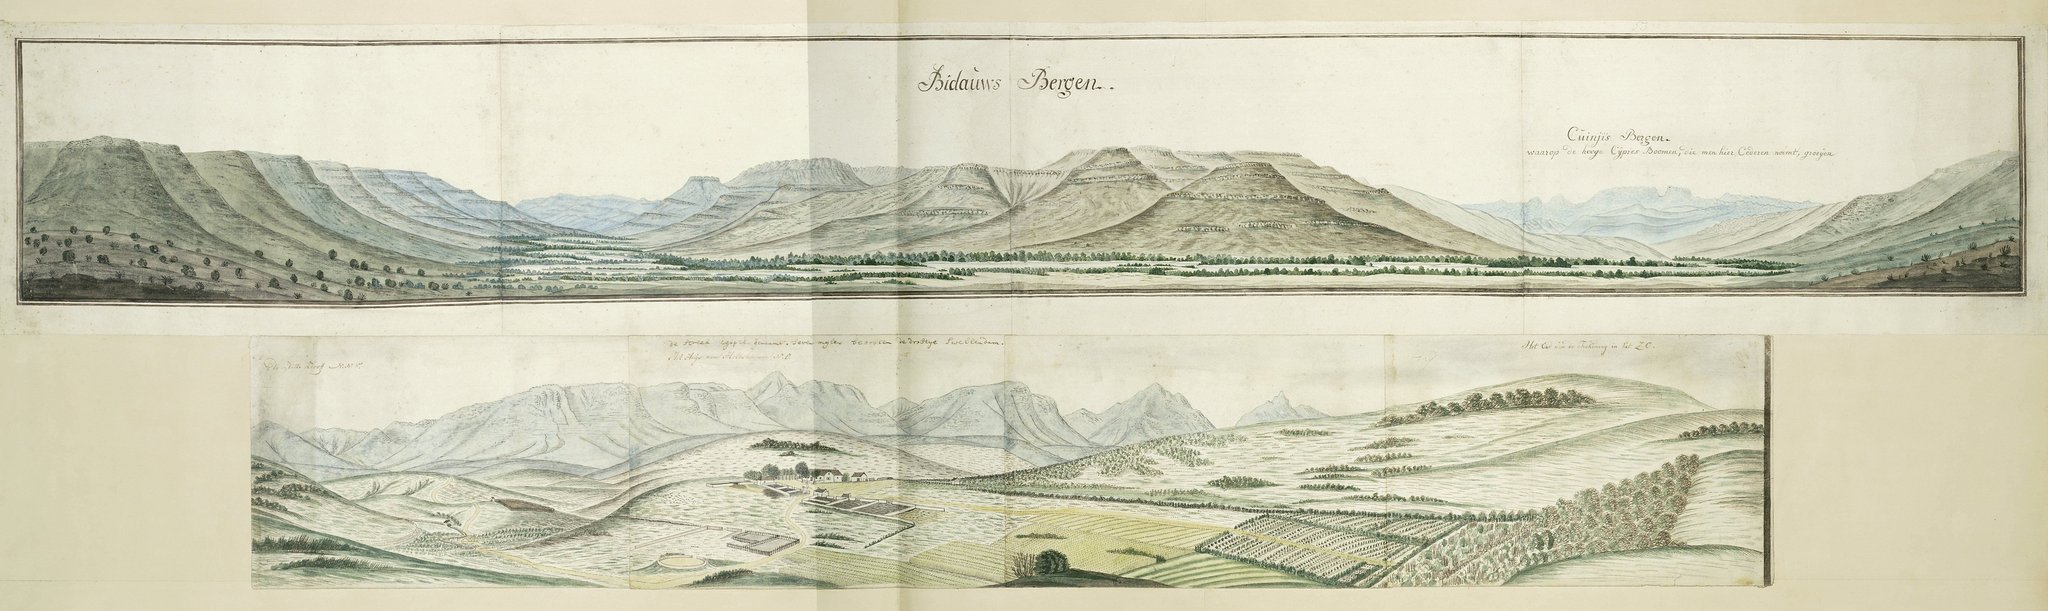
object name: panorama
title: Panorama of the Bidouw- and Cuinjis Mountains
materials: ink, paper, pencil, watercolor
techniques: brush, pen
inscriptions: annotation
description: Oorspronkelijk in omslag van roodkleurig halfleer en roodgemarmerd plat, dorso met ribben en goudopdruk; 71 x 99 x 6 cm.